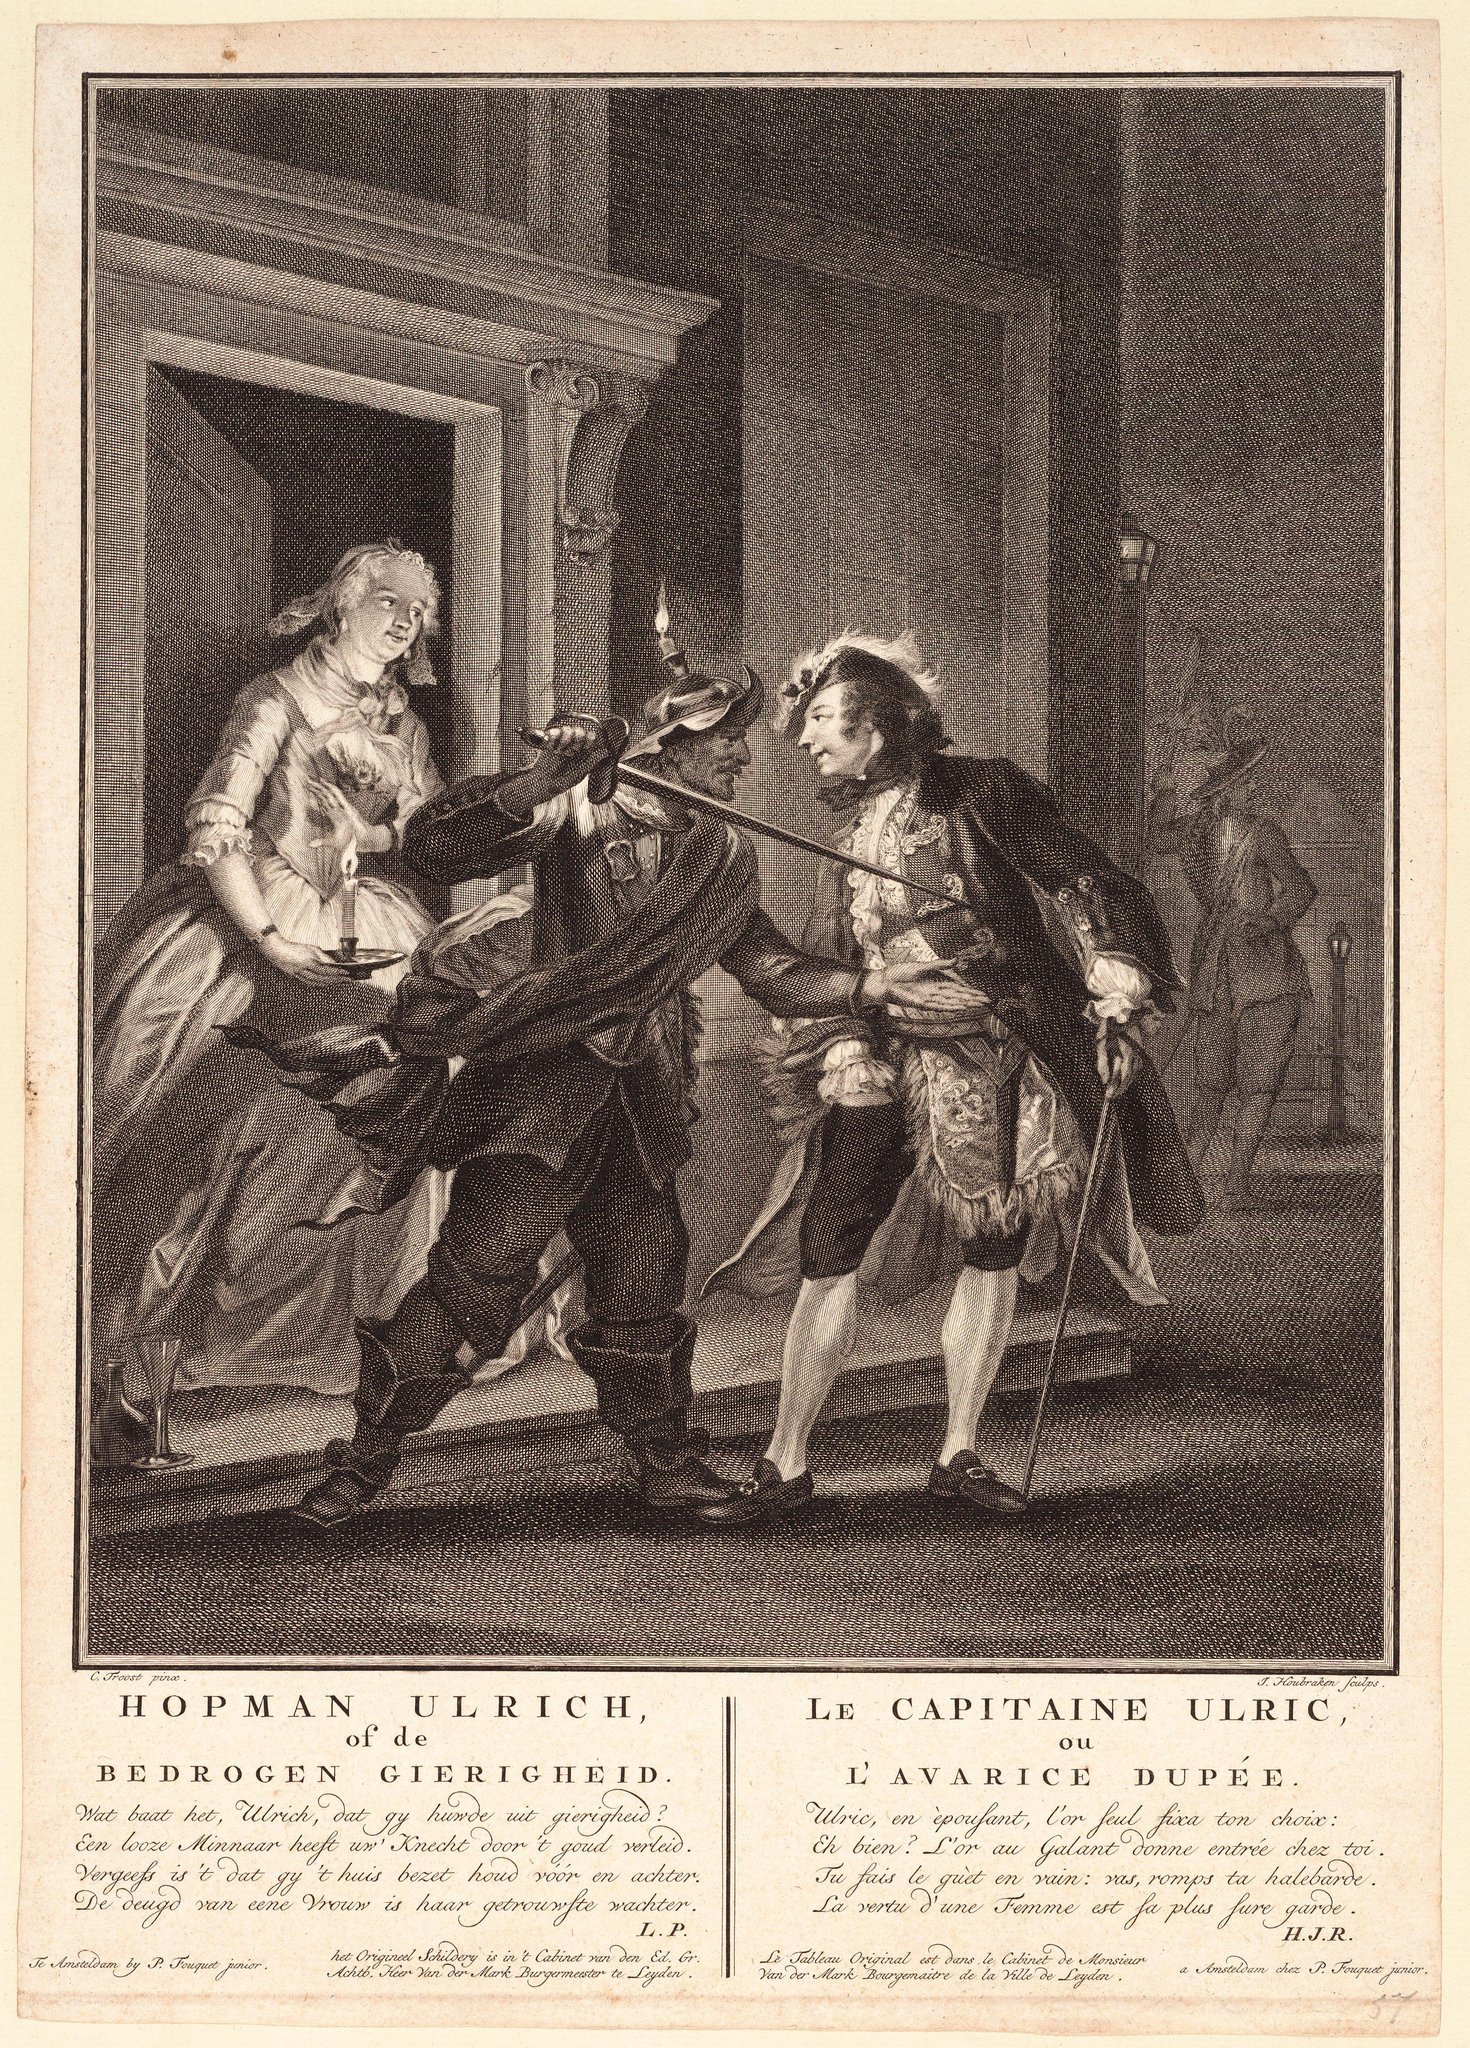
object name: print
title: Hopman Ulrich of de Bedrogen Gierigheid: de omkoping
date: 1760-1780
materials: paper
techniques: engraving, etching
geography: amsterdam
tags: comedy, candlestick, guard duty, keeping sentry, night, bribery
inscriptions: collector's mark: Lugt 2488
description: Een wachter met een zwaard vraagt een jongeman (Godefroy), die heimelijk in de nacht bij zijn geliefde (Sybille) op bezoek komt, om geld. De jongeman steekt zijn hand in zijn broekzak. De vrouw heeft een kaars vast. Op de stoep staan een glas en een fles. Rechts op de achtergrond een tweede wachter. Scène uit het blijspel 'Hopman Ulrich of de bedrogen gierigheid' van Johan van Paffenrode uit 1661, waarin het gierige personage Ulrich wordt bedrogen door zijn vrouw Sybille, ondanks dat hij haar laat bewaken. Haar minnaar Godefroy koopt de wachter om. In de marge twee vierregelige verzen in het Nederlands en het Frans.